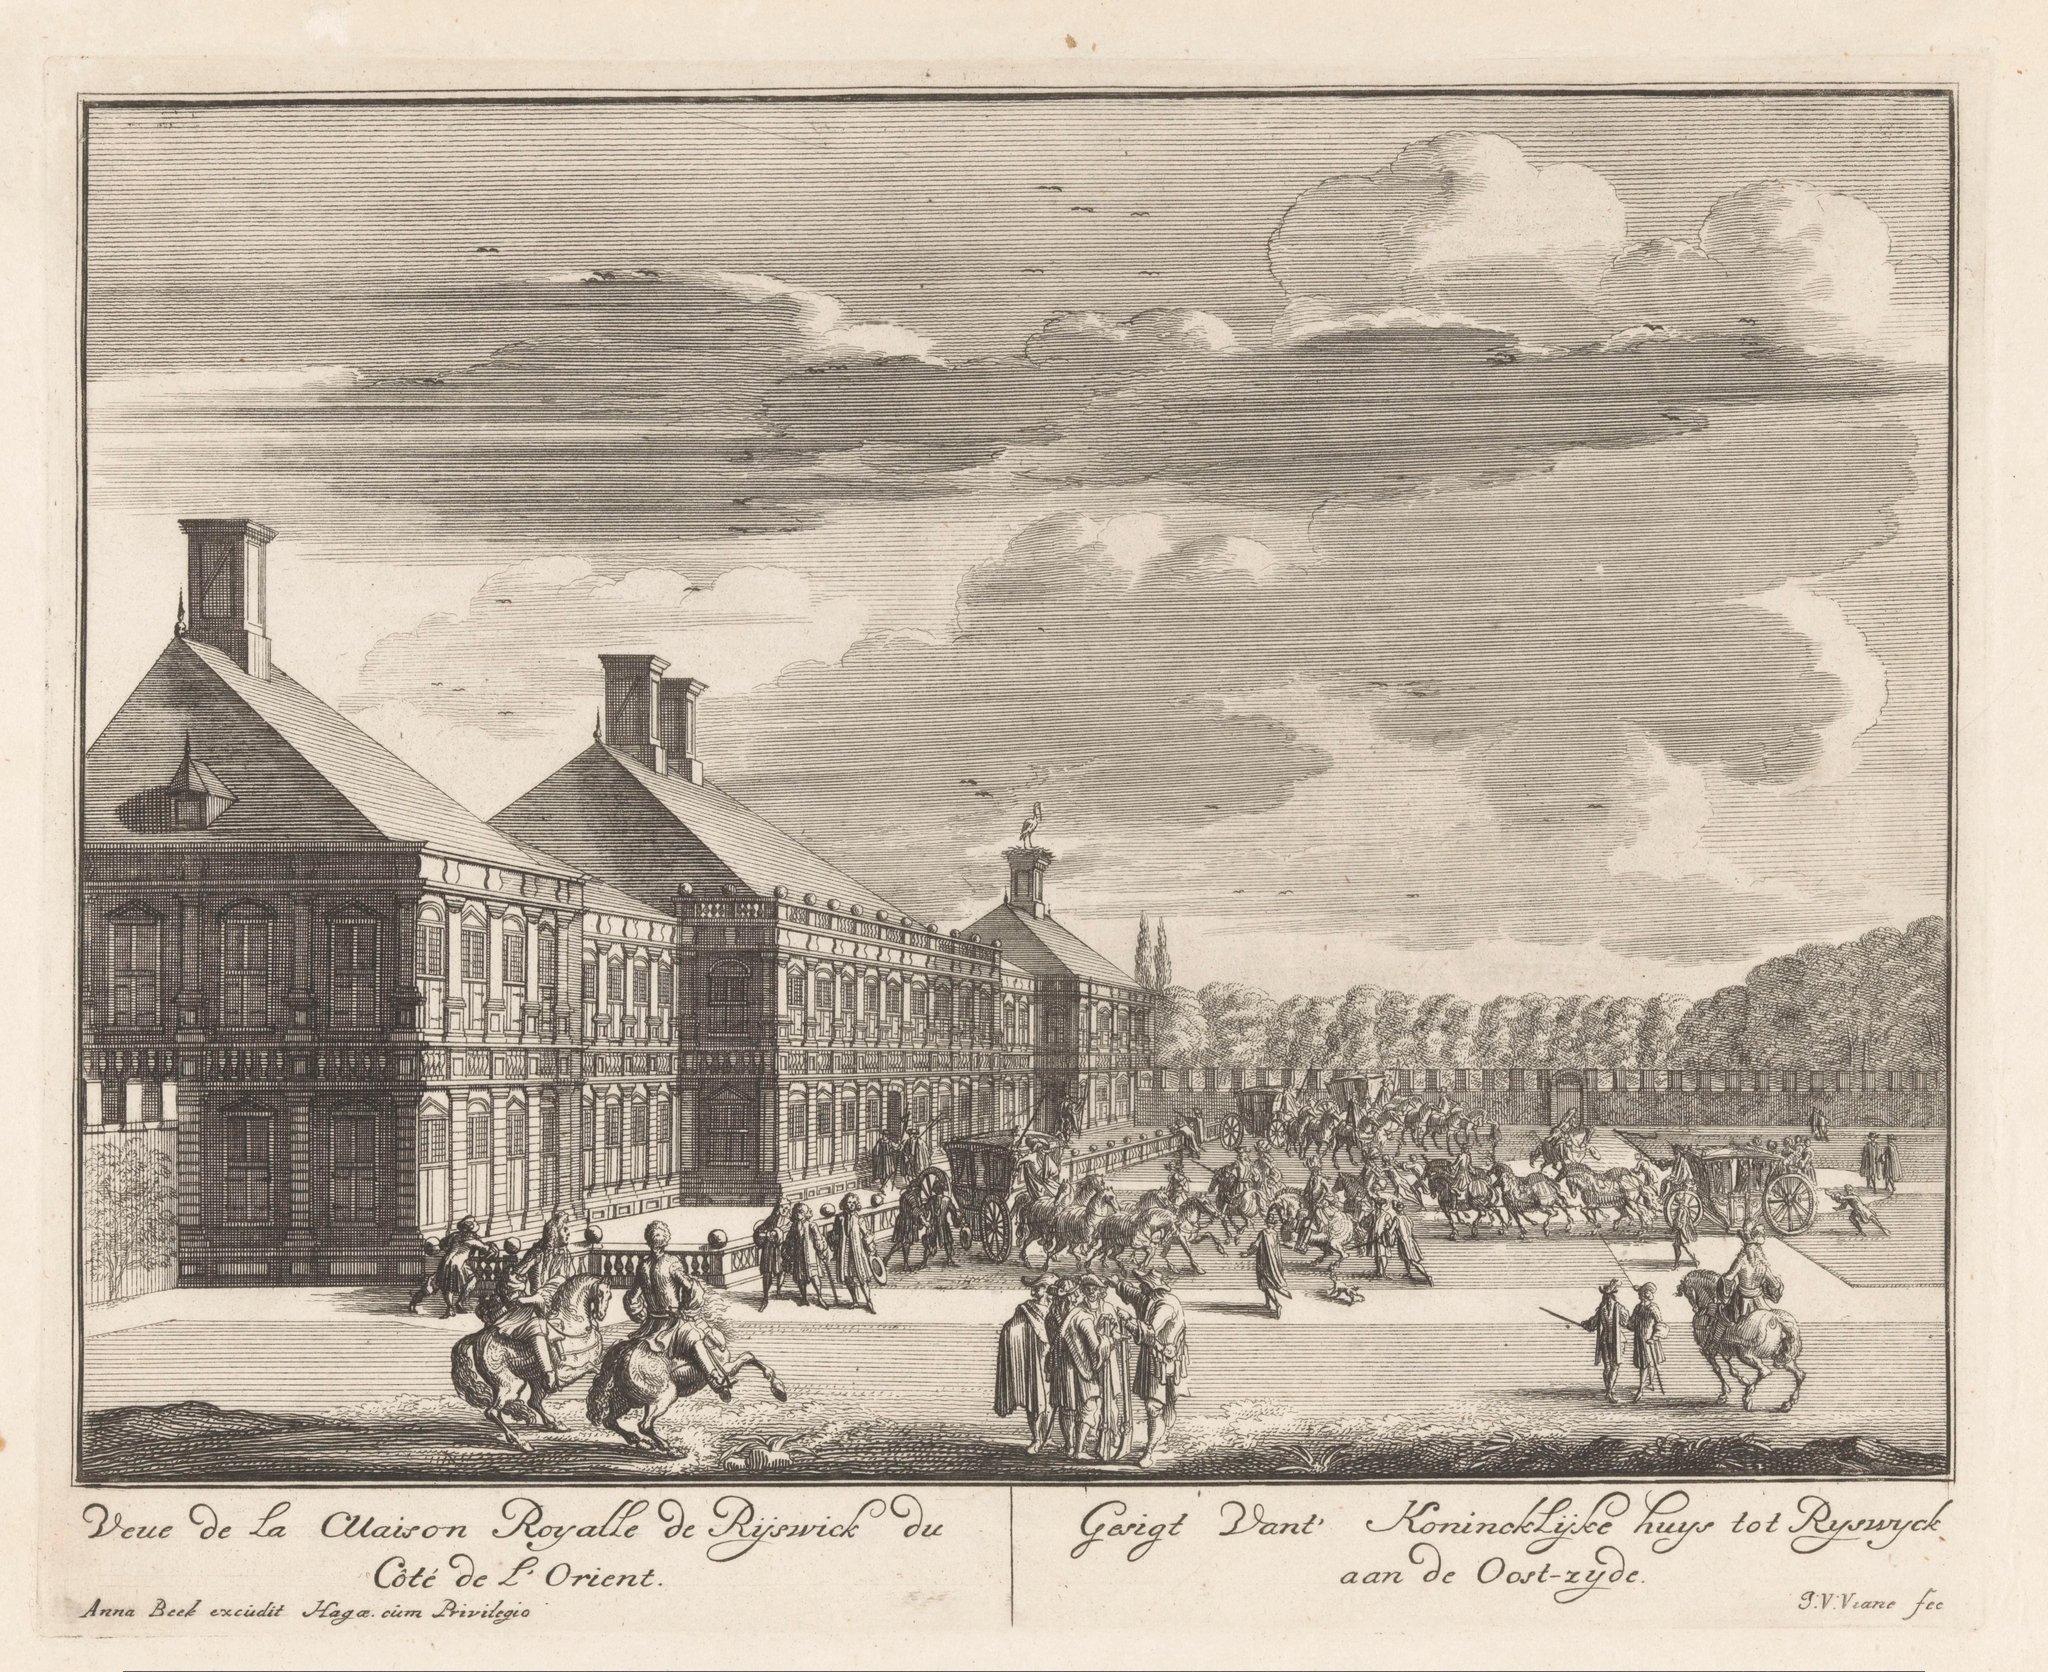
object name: print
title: Gesigt vant' konincklijke huys tot Ryswyck aan de oost-zyde / Veue de la maison royalle de Rijswick du côté de l'orient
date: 1697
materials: paper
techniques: etching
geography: northern netherlands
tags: palace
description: Gezicht op het Huis ter Nieuburch in Rijswijk, oostzijde. In het onderschrift de twee titels in het Frans en Nederlands. Onderdeel (prent 3) van de serie van vijftien prenten over het Huis ter Nieuburch in Rijswijk en de daar gehouden vredesonderhandelingen resulterend in de Vrede van Rijswijk gesloten op 20 september 1697.